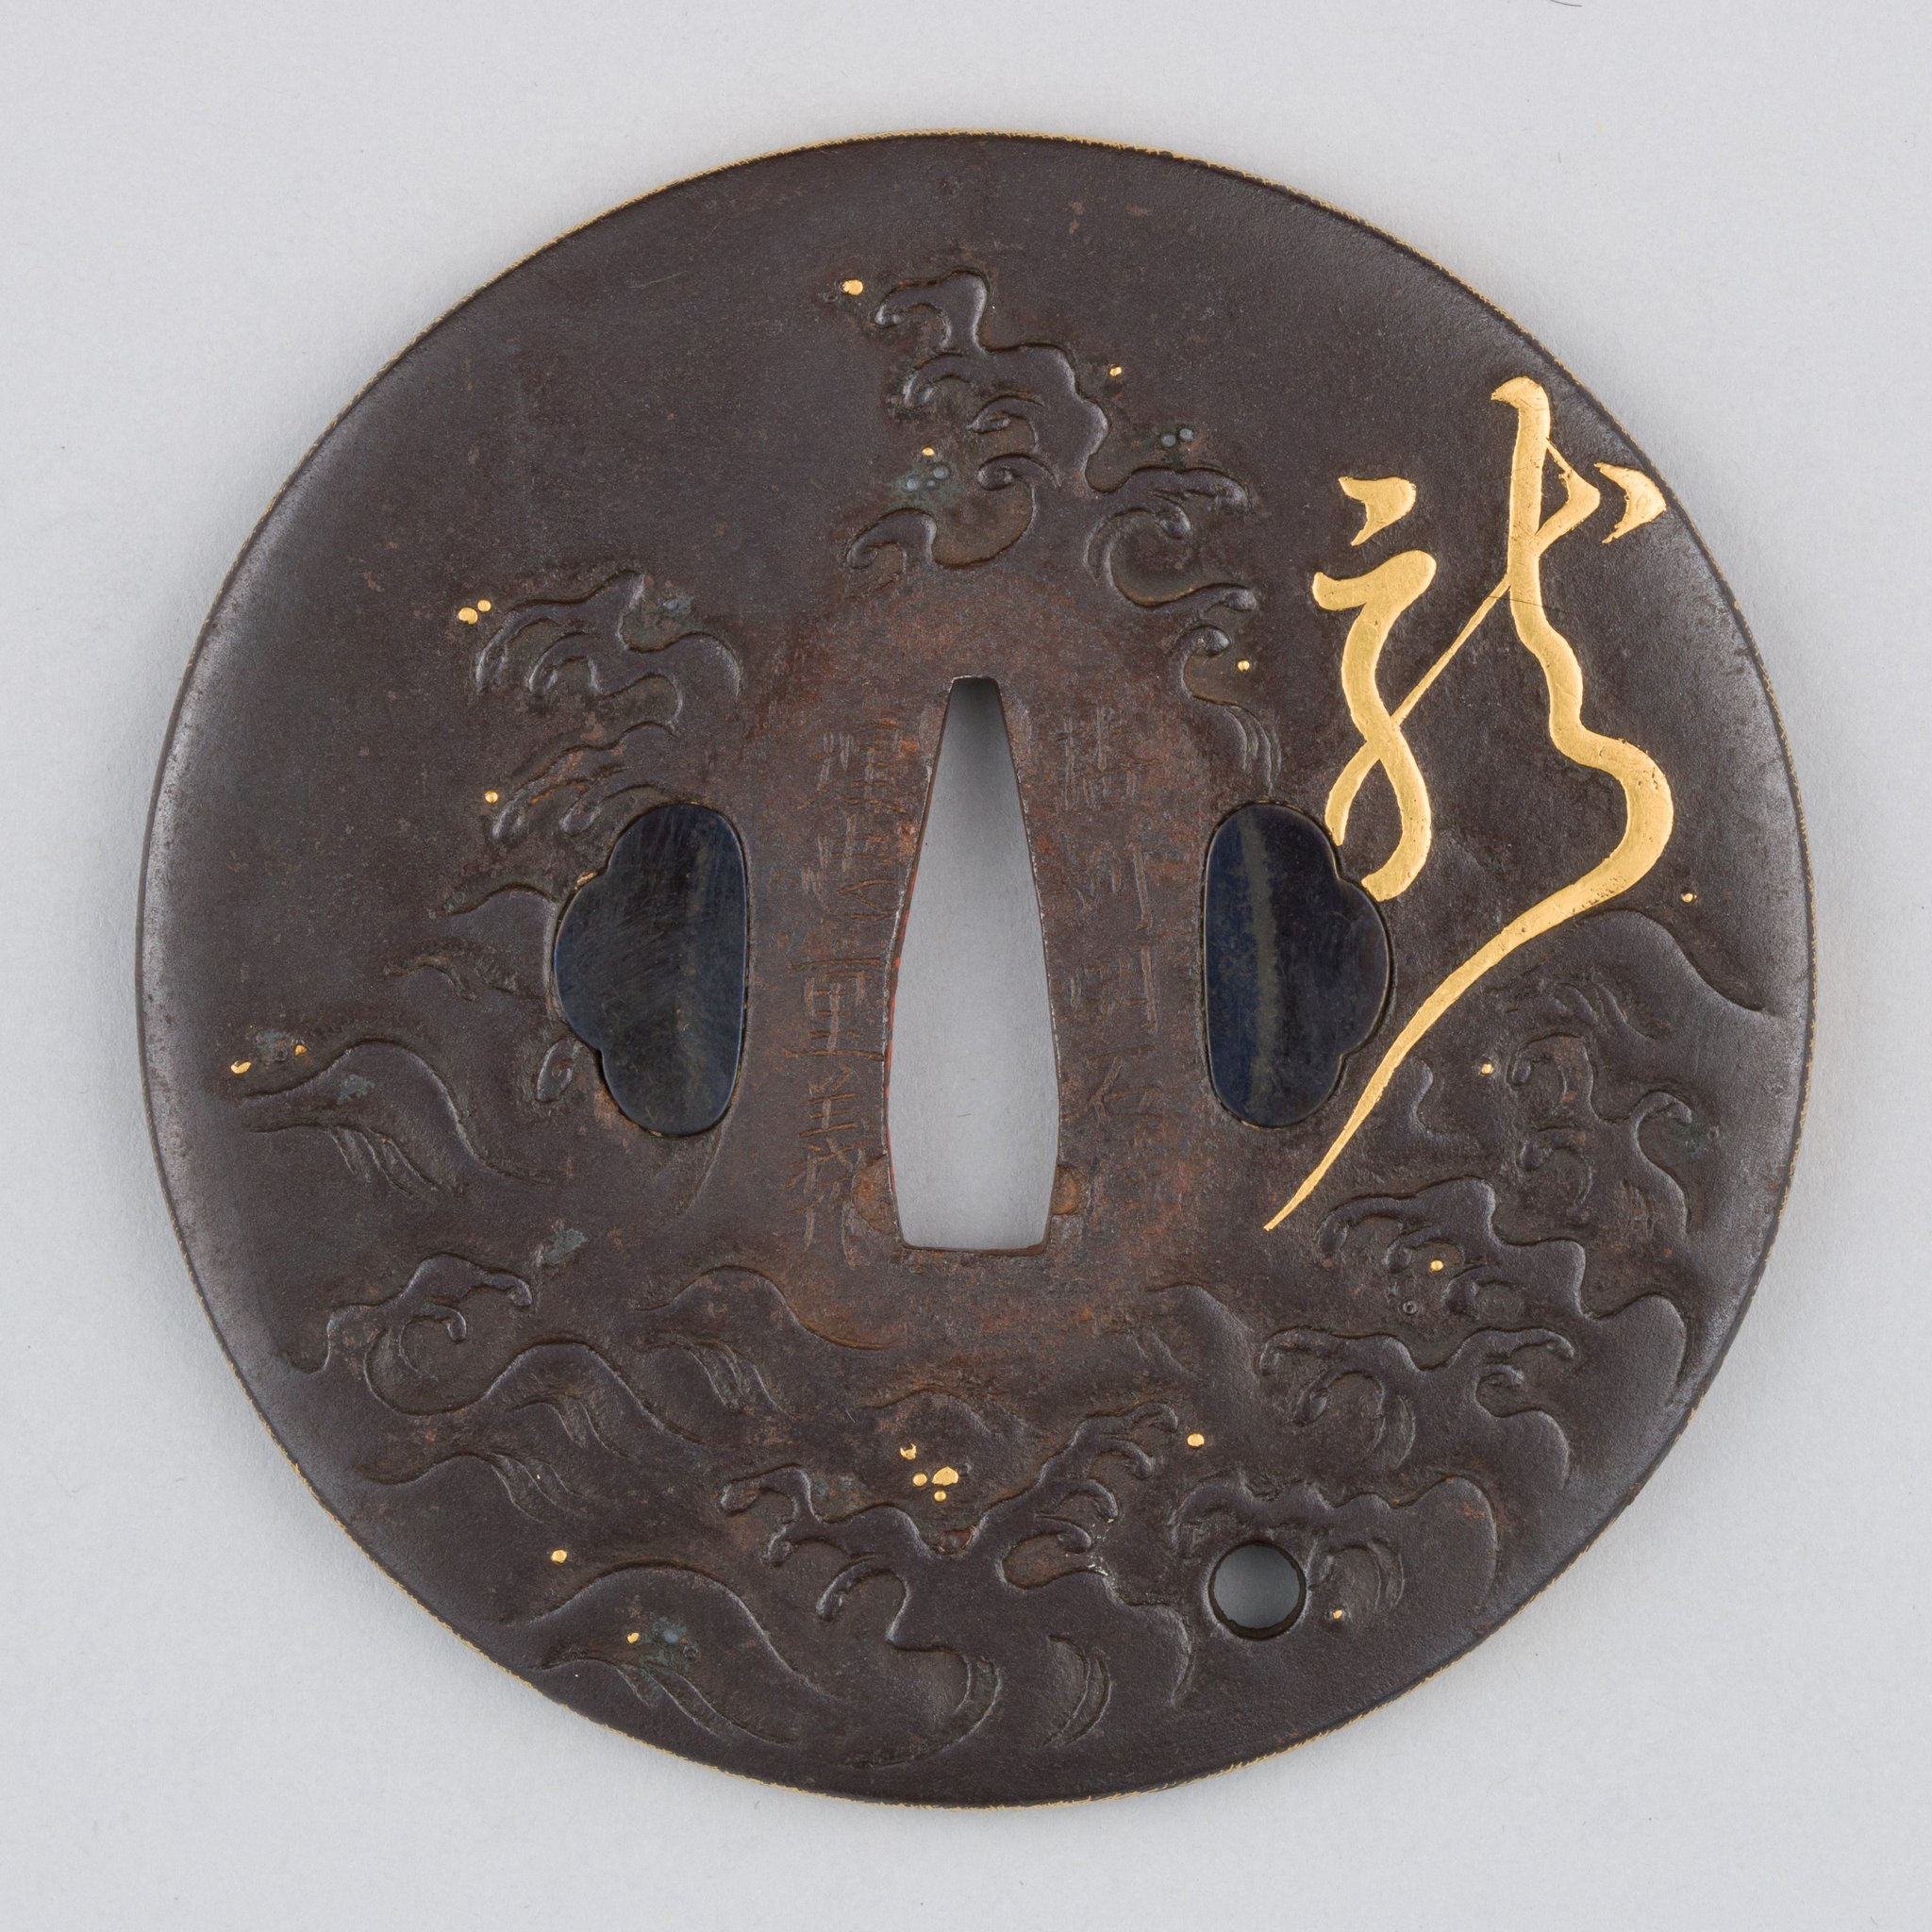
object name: sword guard tsuba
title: Sword Guard (Tsuba)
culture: japanese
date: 1701-1800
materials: copper, gold alloy, gold, iron, silver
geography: japan